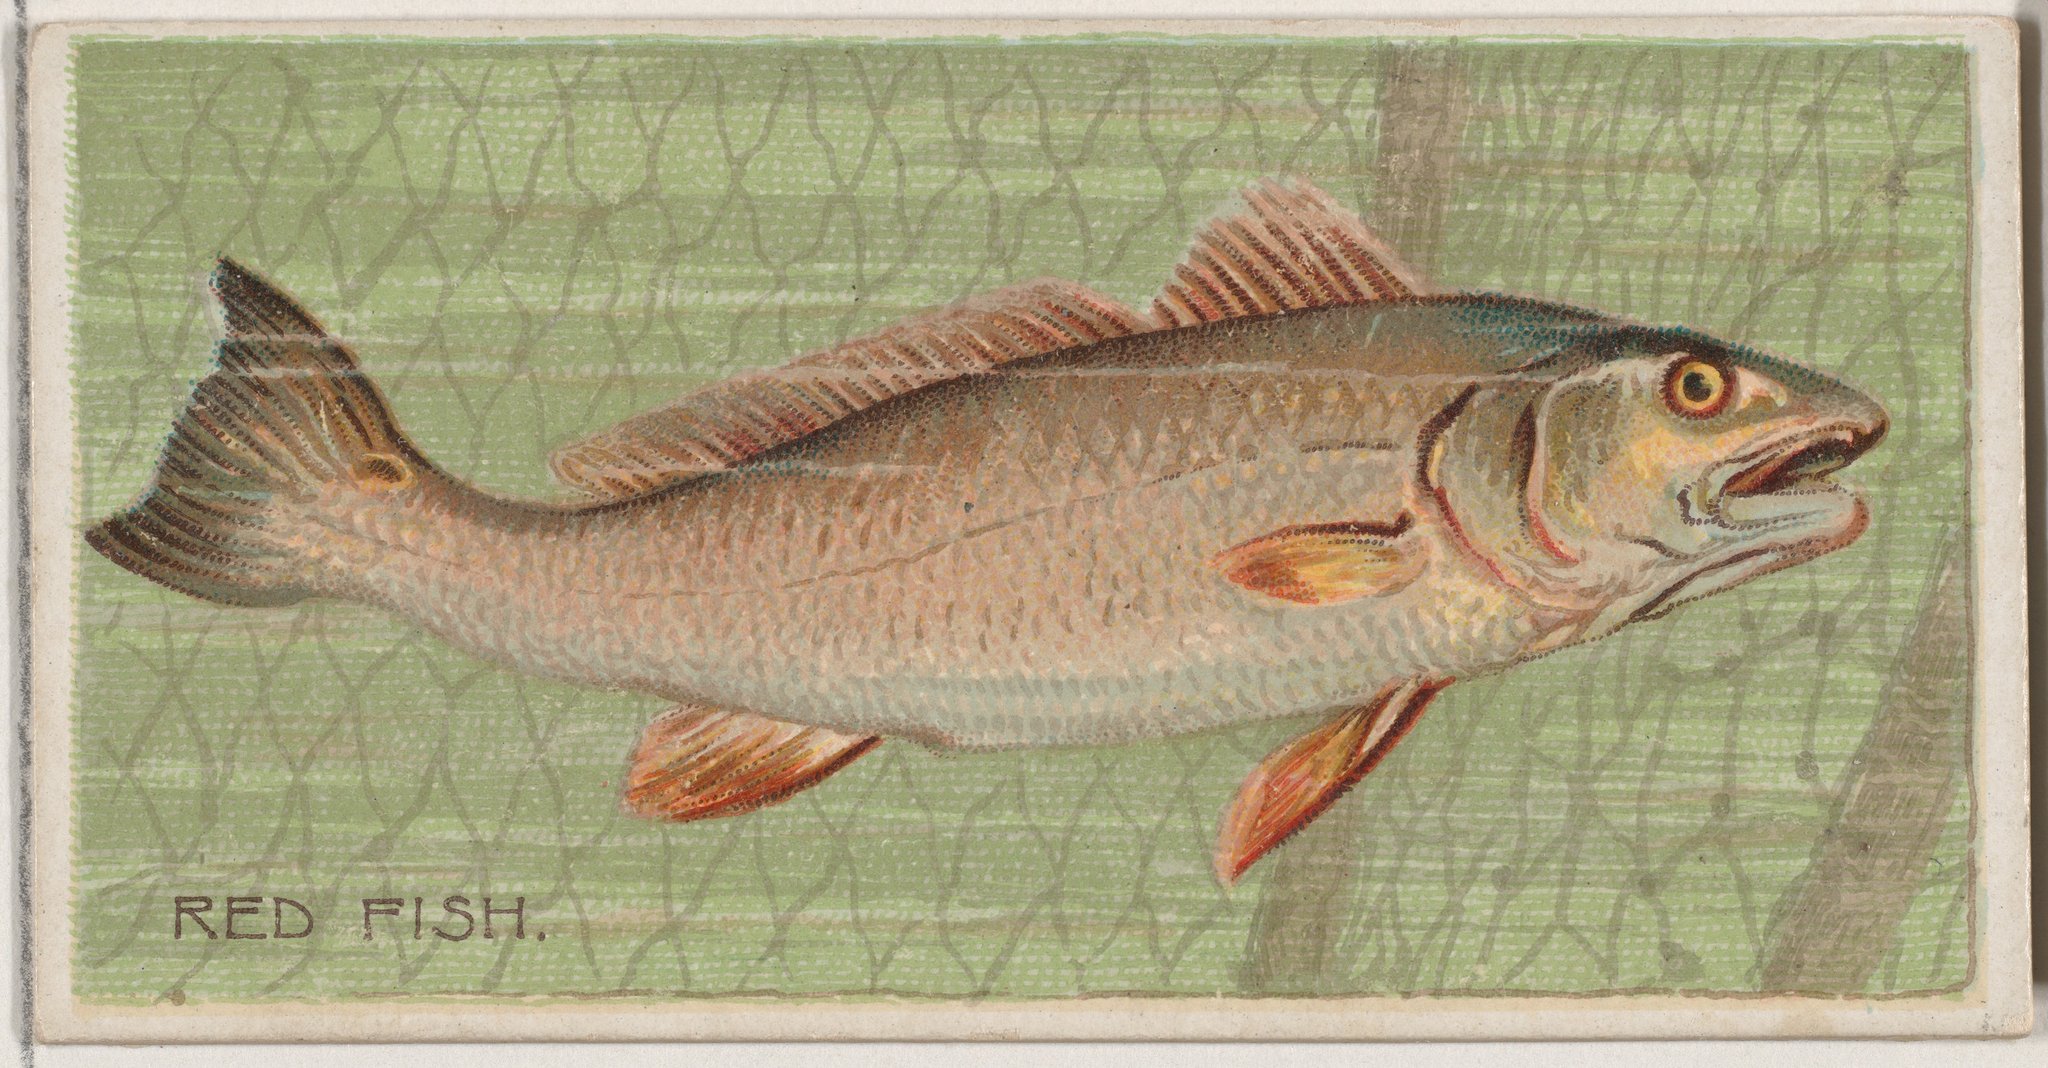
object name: print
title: Red Fish, from the series Fishers and Fish (N74) for Duke brand cigarettes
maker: knapp & company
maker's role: lithographer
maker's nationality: american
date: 1888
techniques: color lithograph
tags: fish